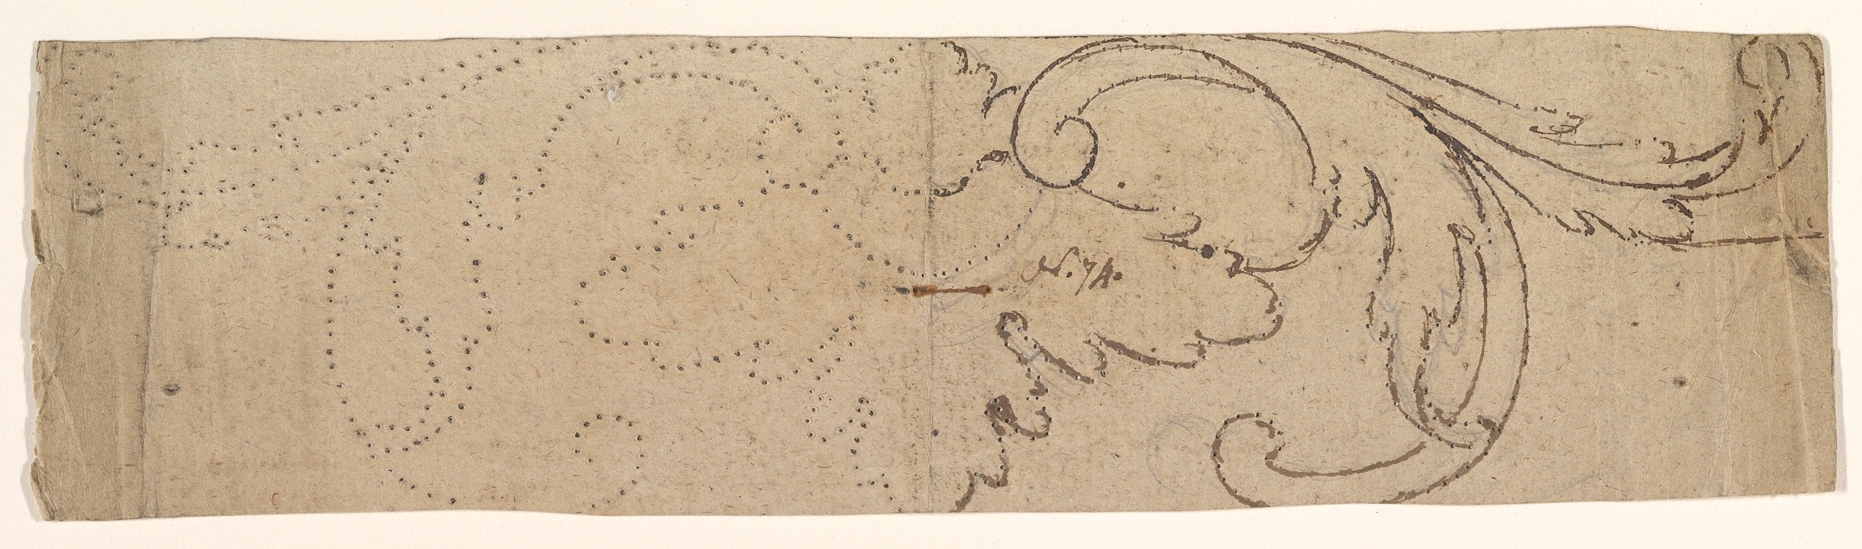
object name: drawing ornament architecture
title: Desing for a Foliate Vignette, from the so-called Scrapbook of Gideon Saint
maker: gideon saint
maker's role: artist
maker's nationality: british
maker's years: 1729-1799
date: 1760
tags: ornament